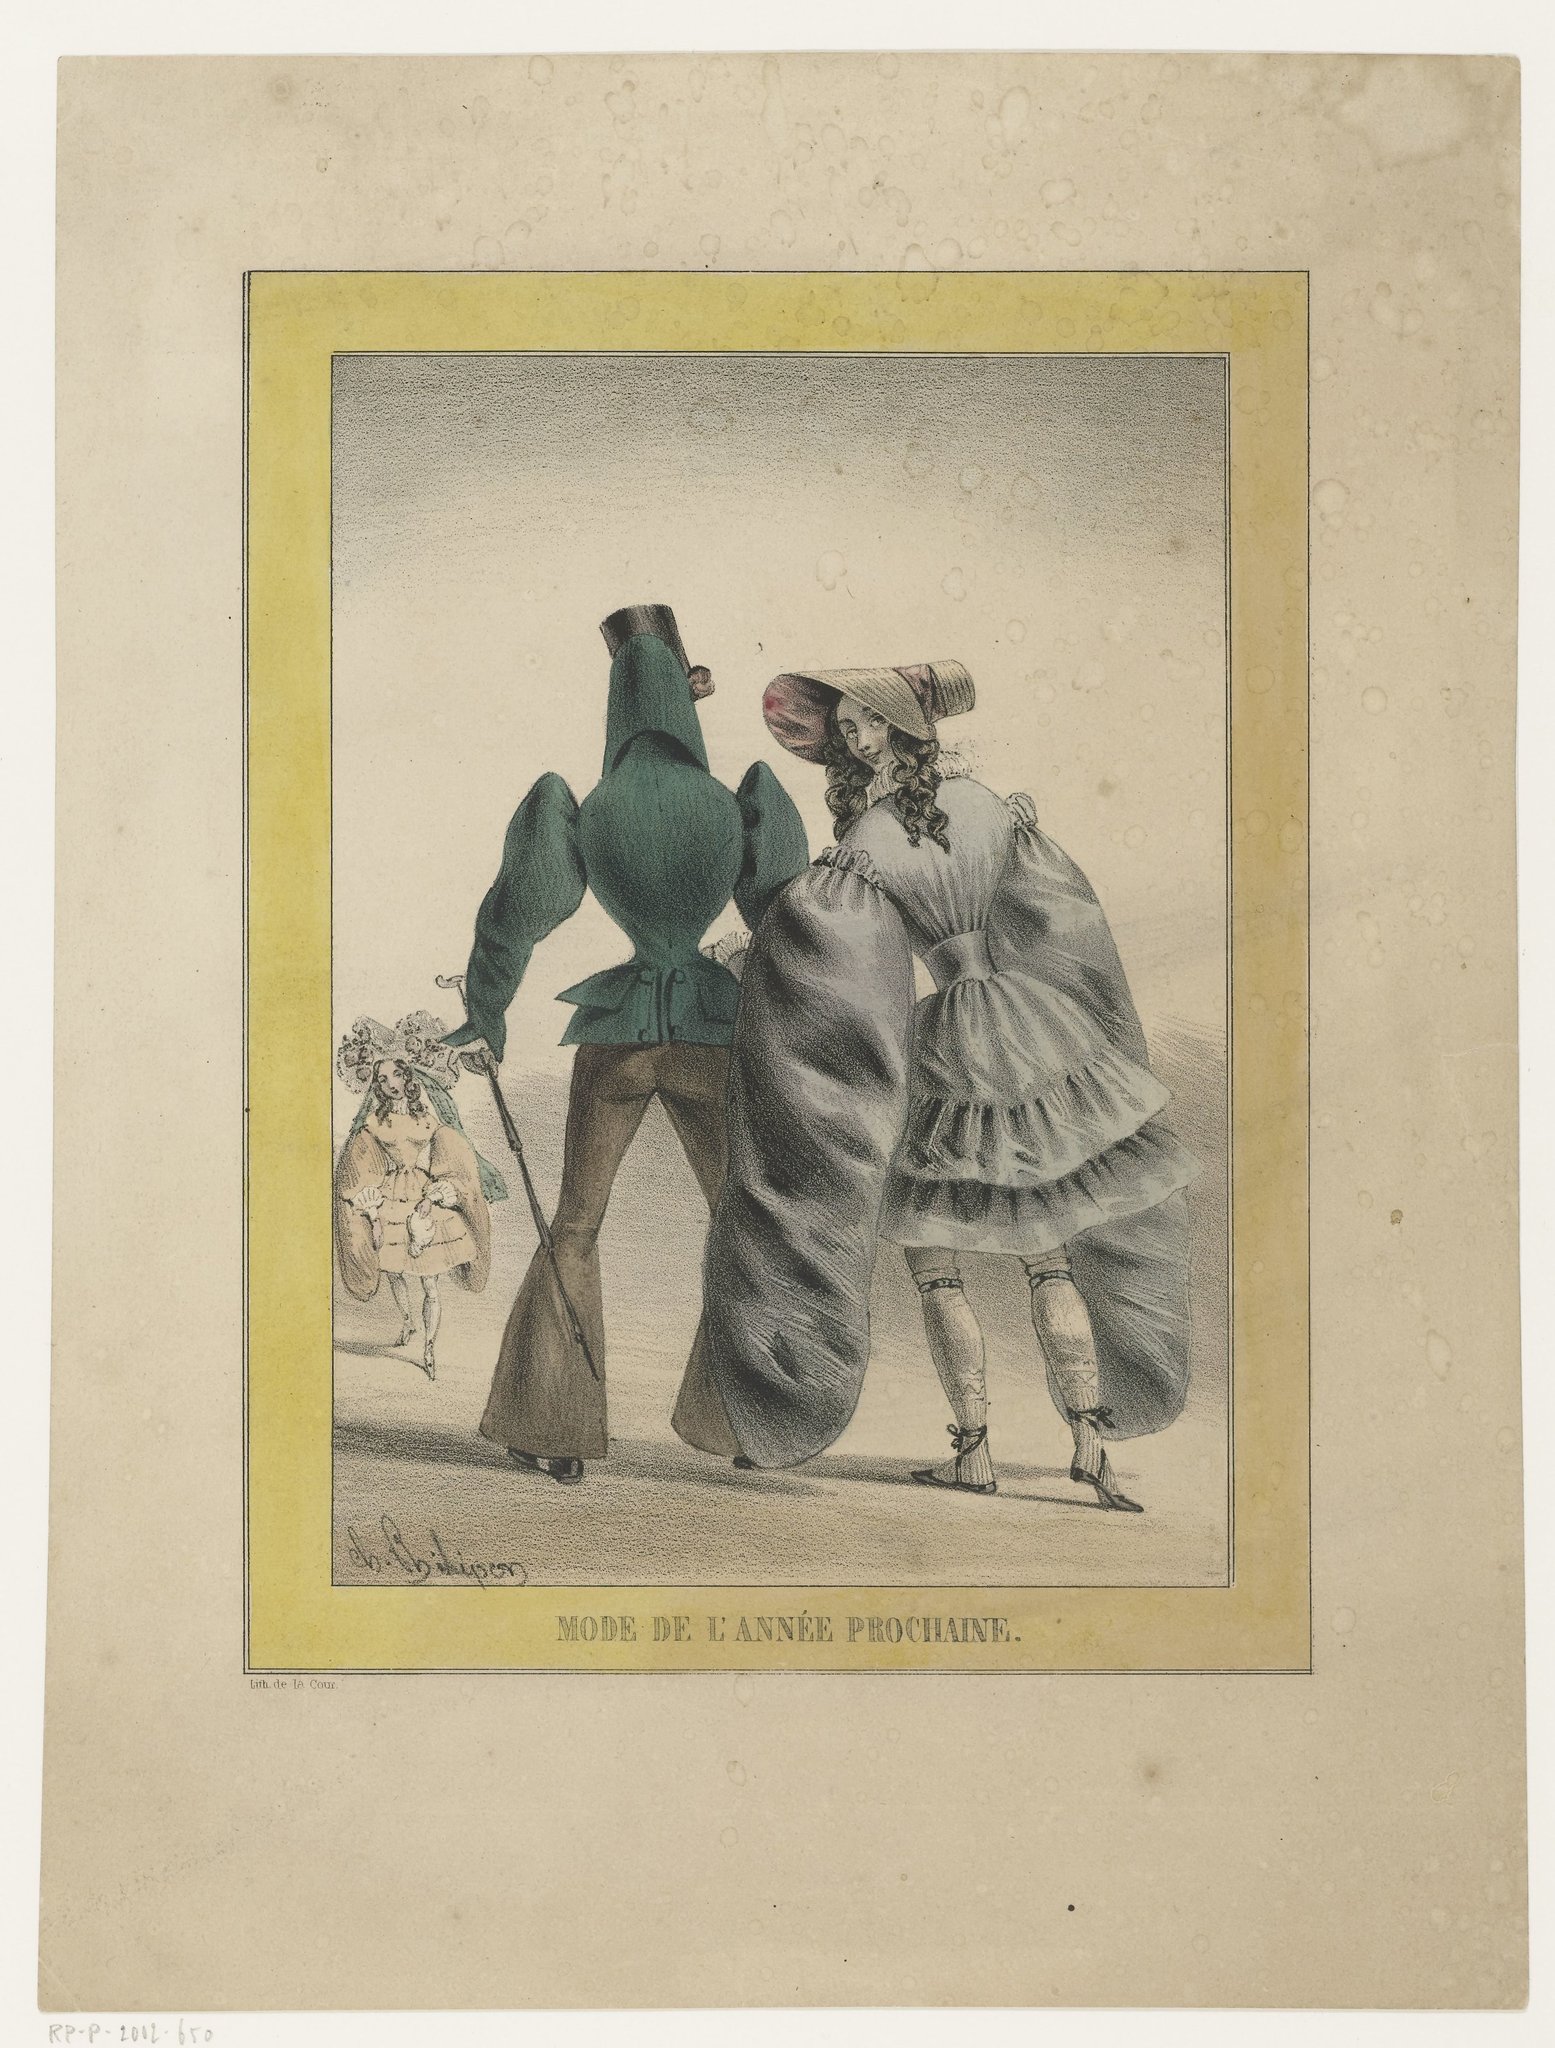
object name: cartoon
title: Man en vrouw in futuristische mode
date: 1831-1844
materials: paper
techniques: hand coloring, lithograph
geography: paris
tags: fashion, clothing, adult woman, adult man, clothes, costume (+ men's clothes)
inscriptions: collector's mark: Lugt 2228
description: Man en vrouw op de rug gezien. De dame is gekleed in japon tot aan de knieen, met extreem lange pofmouwen die tot op de grond hangen. Spotprent.